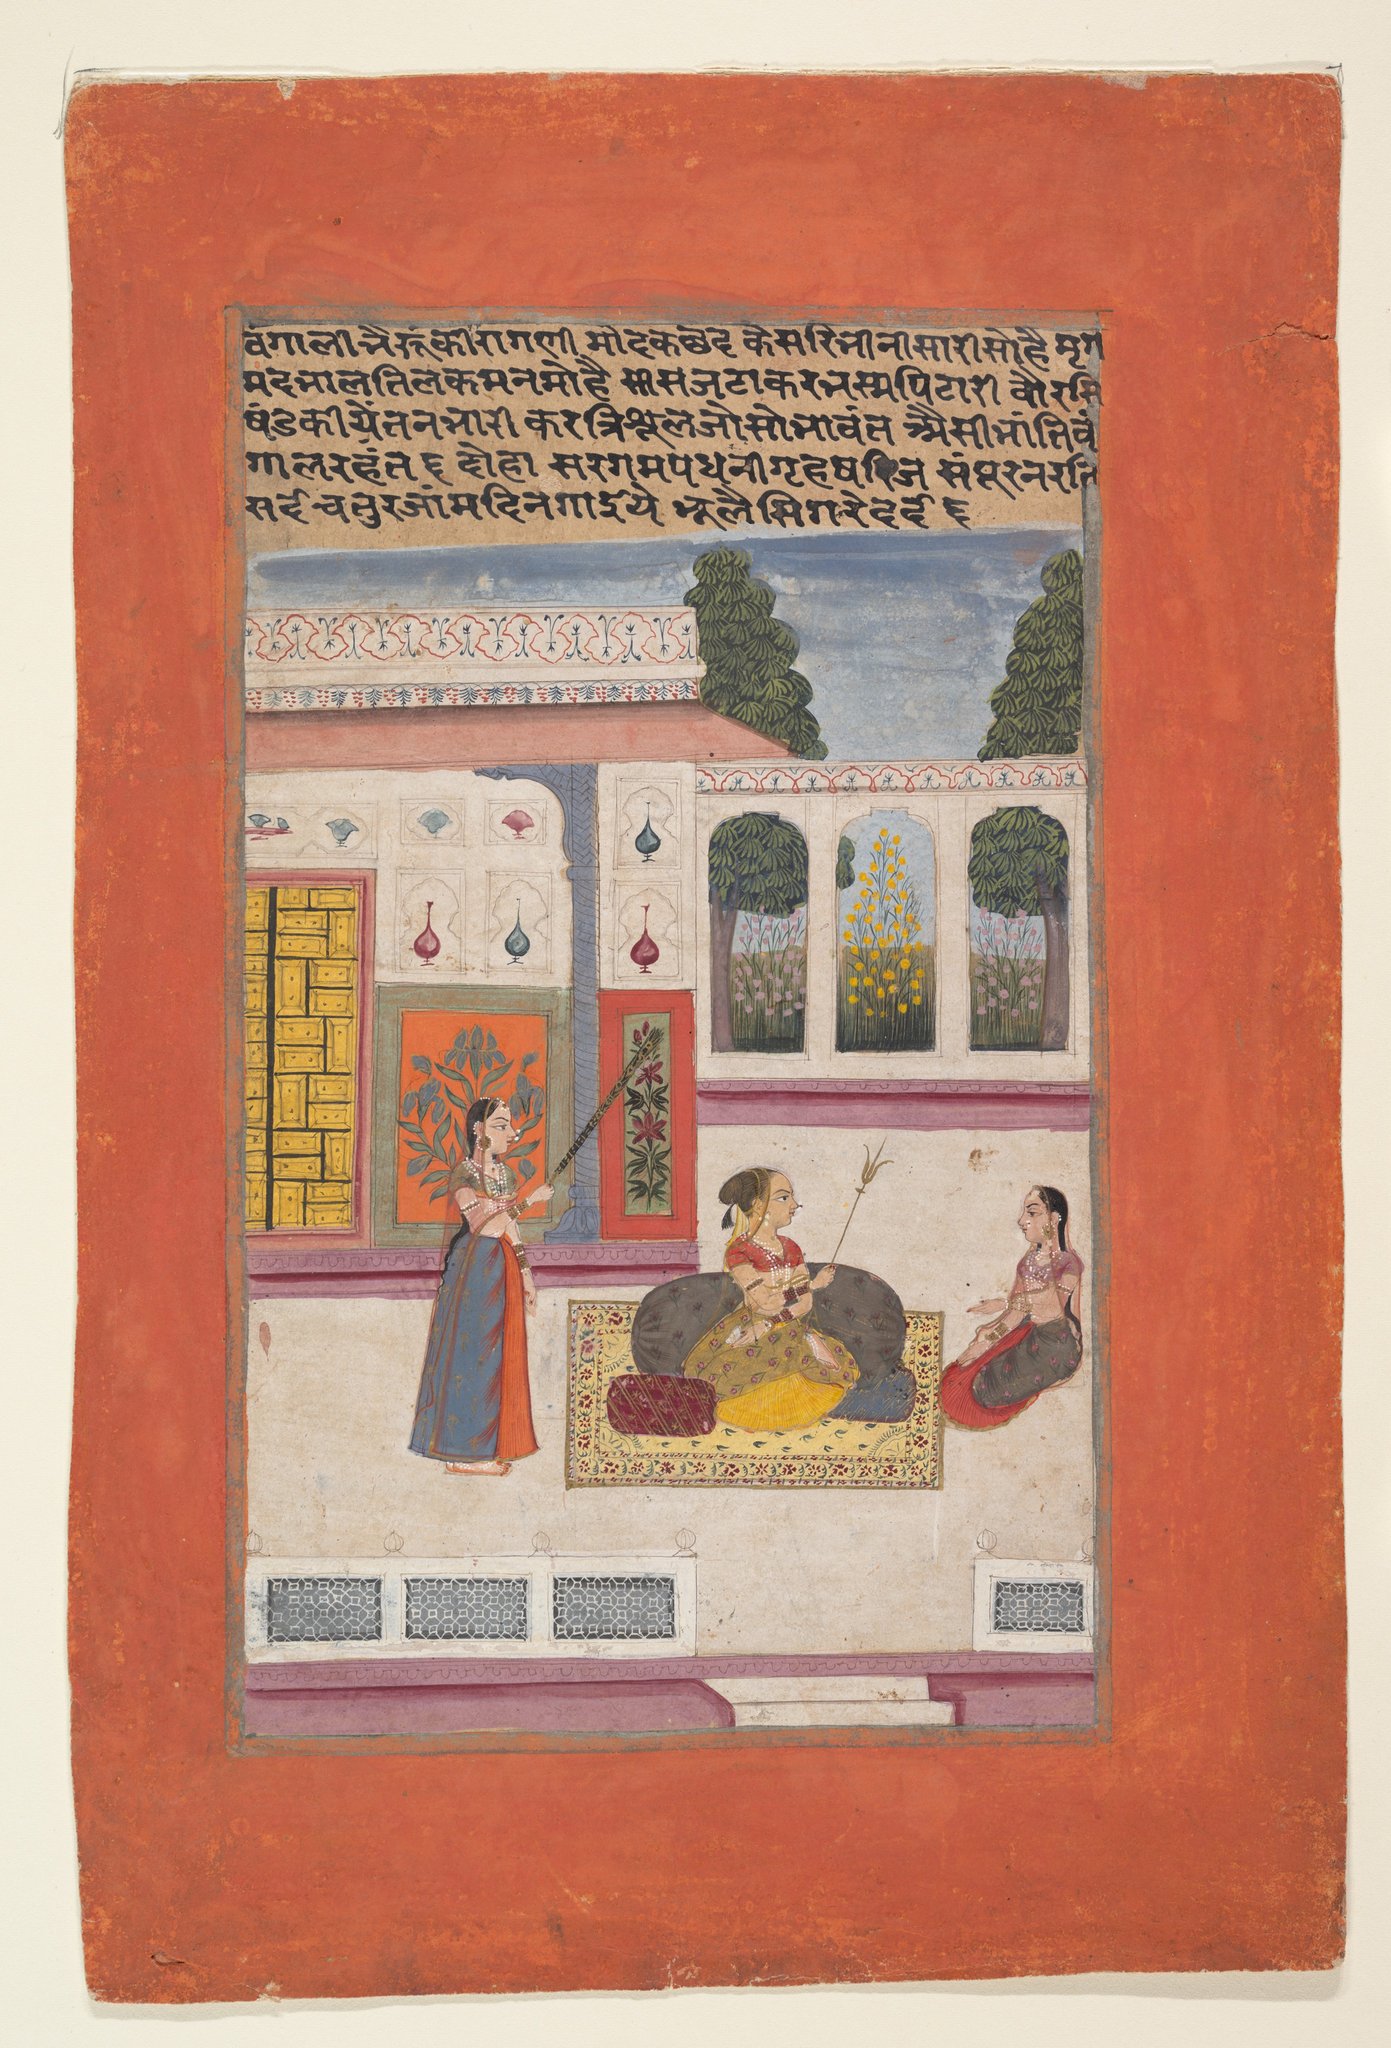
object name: folio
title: Bangali Ragini: Folio from a ragamala series (Garland of Musical Modes)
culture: indian or rajasthan or amber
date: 1709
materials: gilt, ink, paper, watercolor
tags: women